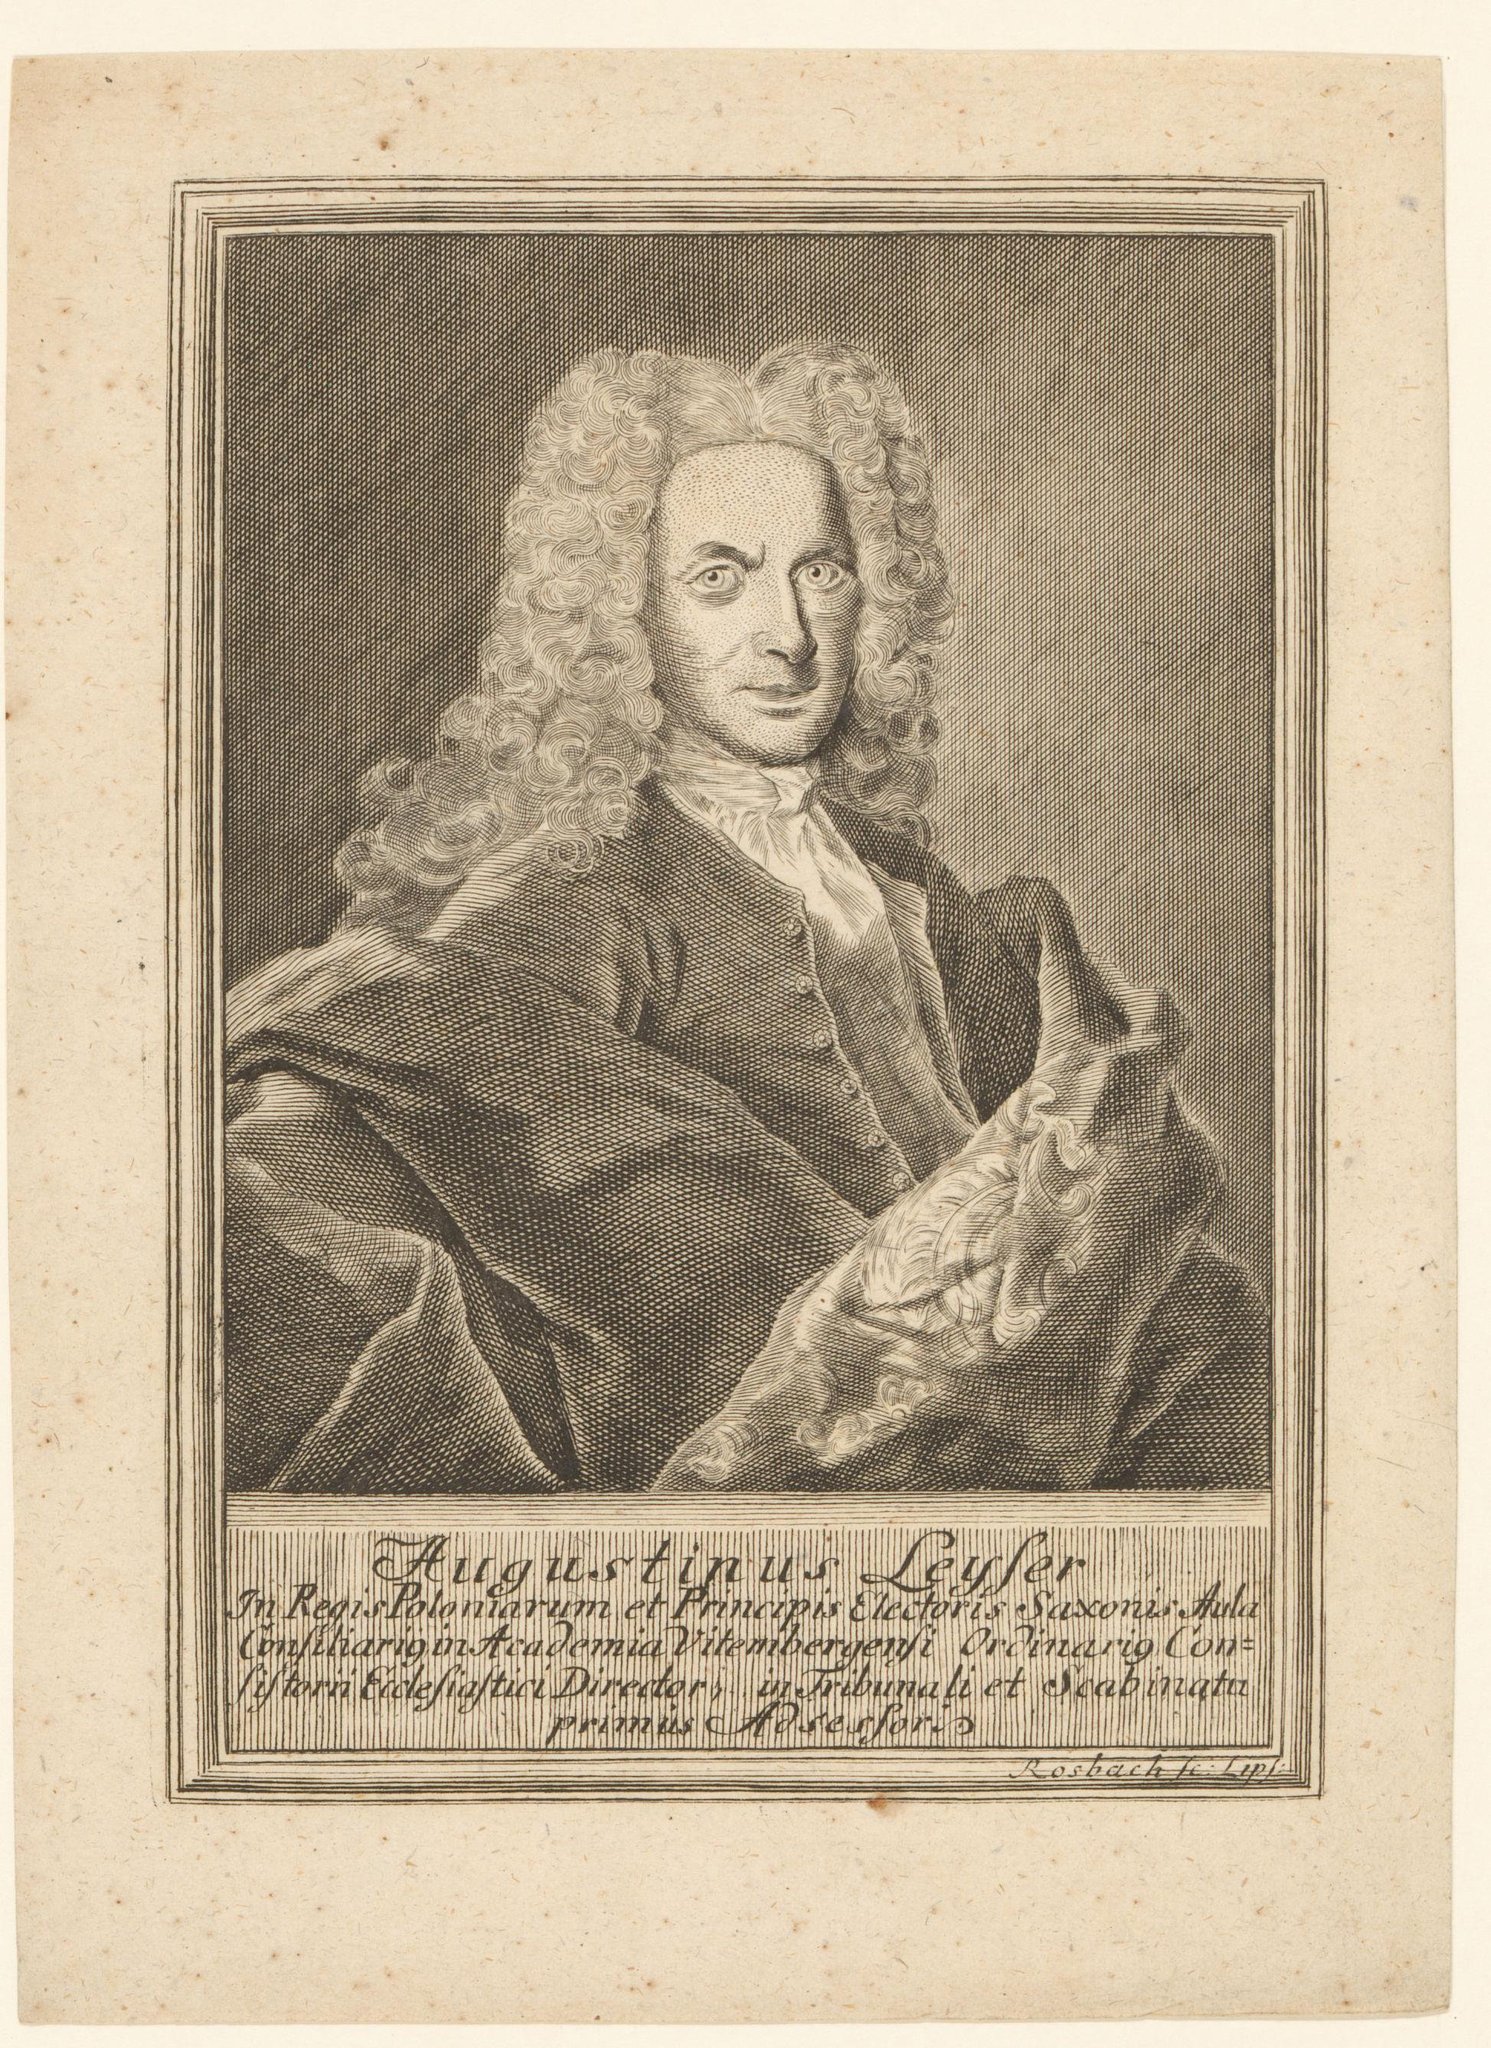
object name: print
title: Portret van Augustin Leyser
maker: johann friedrich rosbach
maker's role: print maker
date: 1700-1749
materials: paper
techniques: engraving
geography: leipzig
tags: historical persons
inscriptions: collector's mark: Lugt 2228